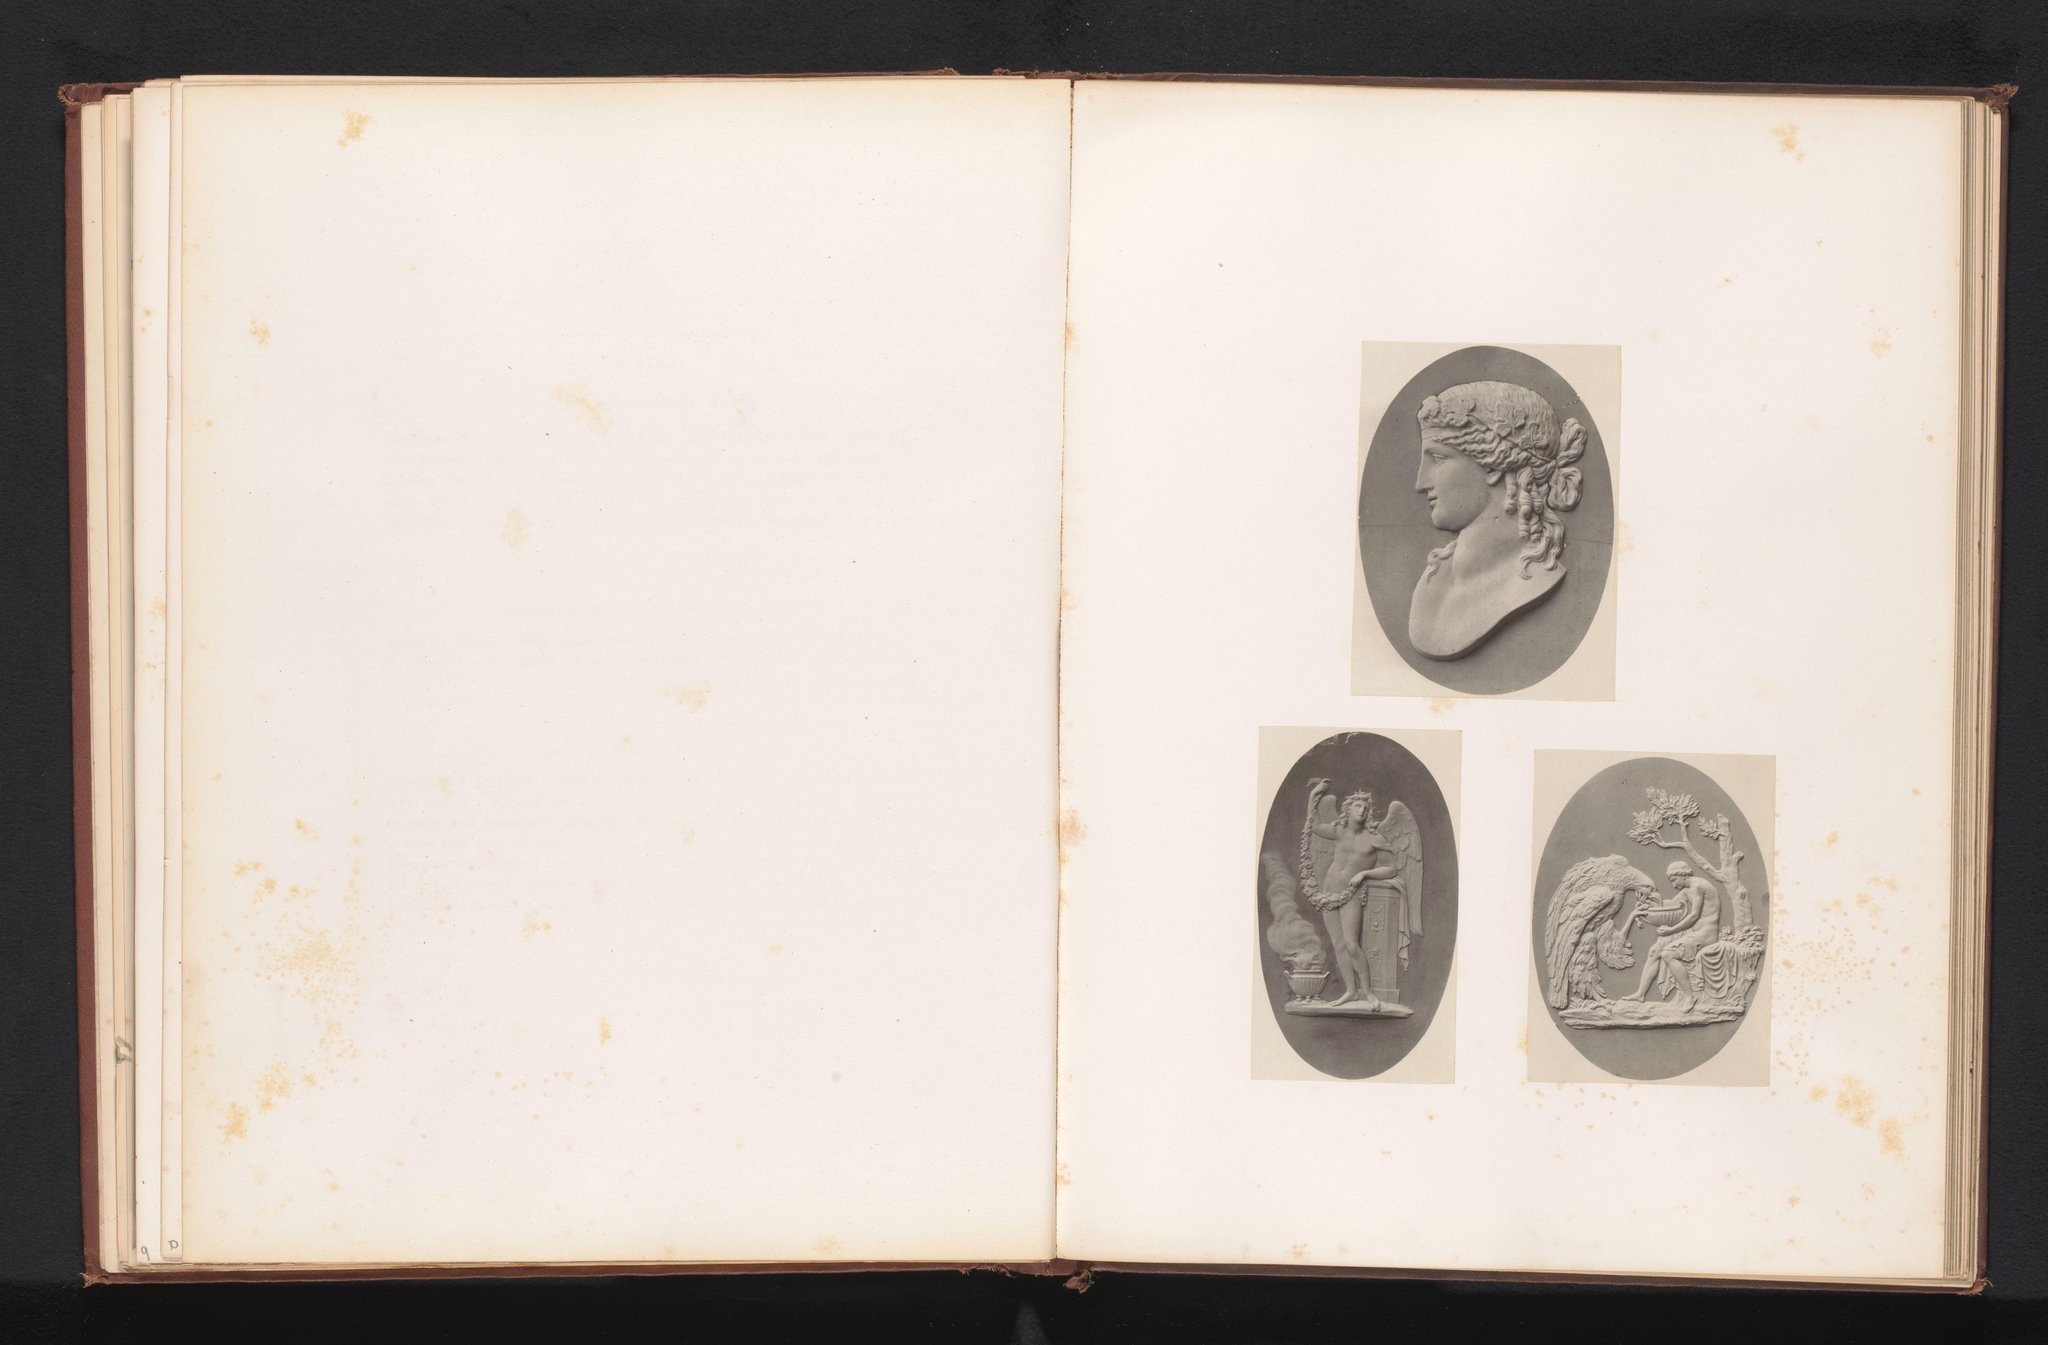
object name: page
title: Bas-reliëfs van een maenade, Flora en Ganymedes met de adelaar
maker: joseph cundall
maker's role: fotograaf, schrijver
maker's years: 1818-1895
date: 1868-1873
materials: paper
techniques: carbon print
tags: maenad(s), female bacchant(es), (story of) flora, attributes of jupiter, sculpture (+ relief ~ sculpture)